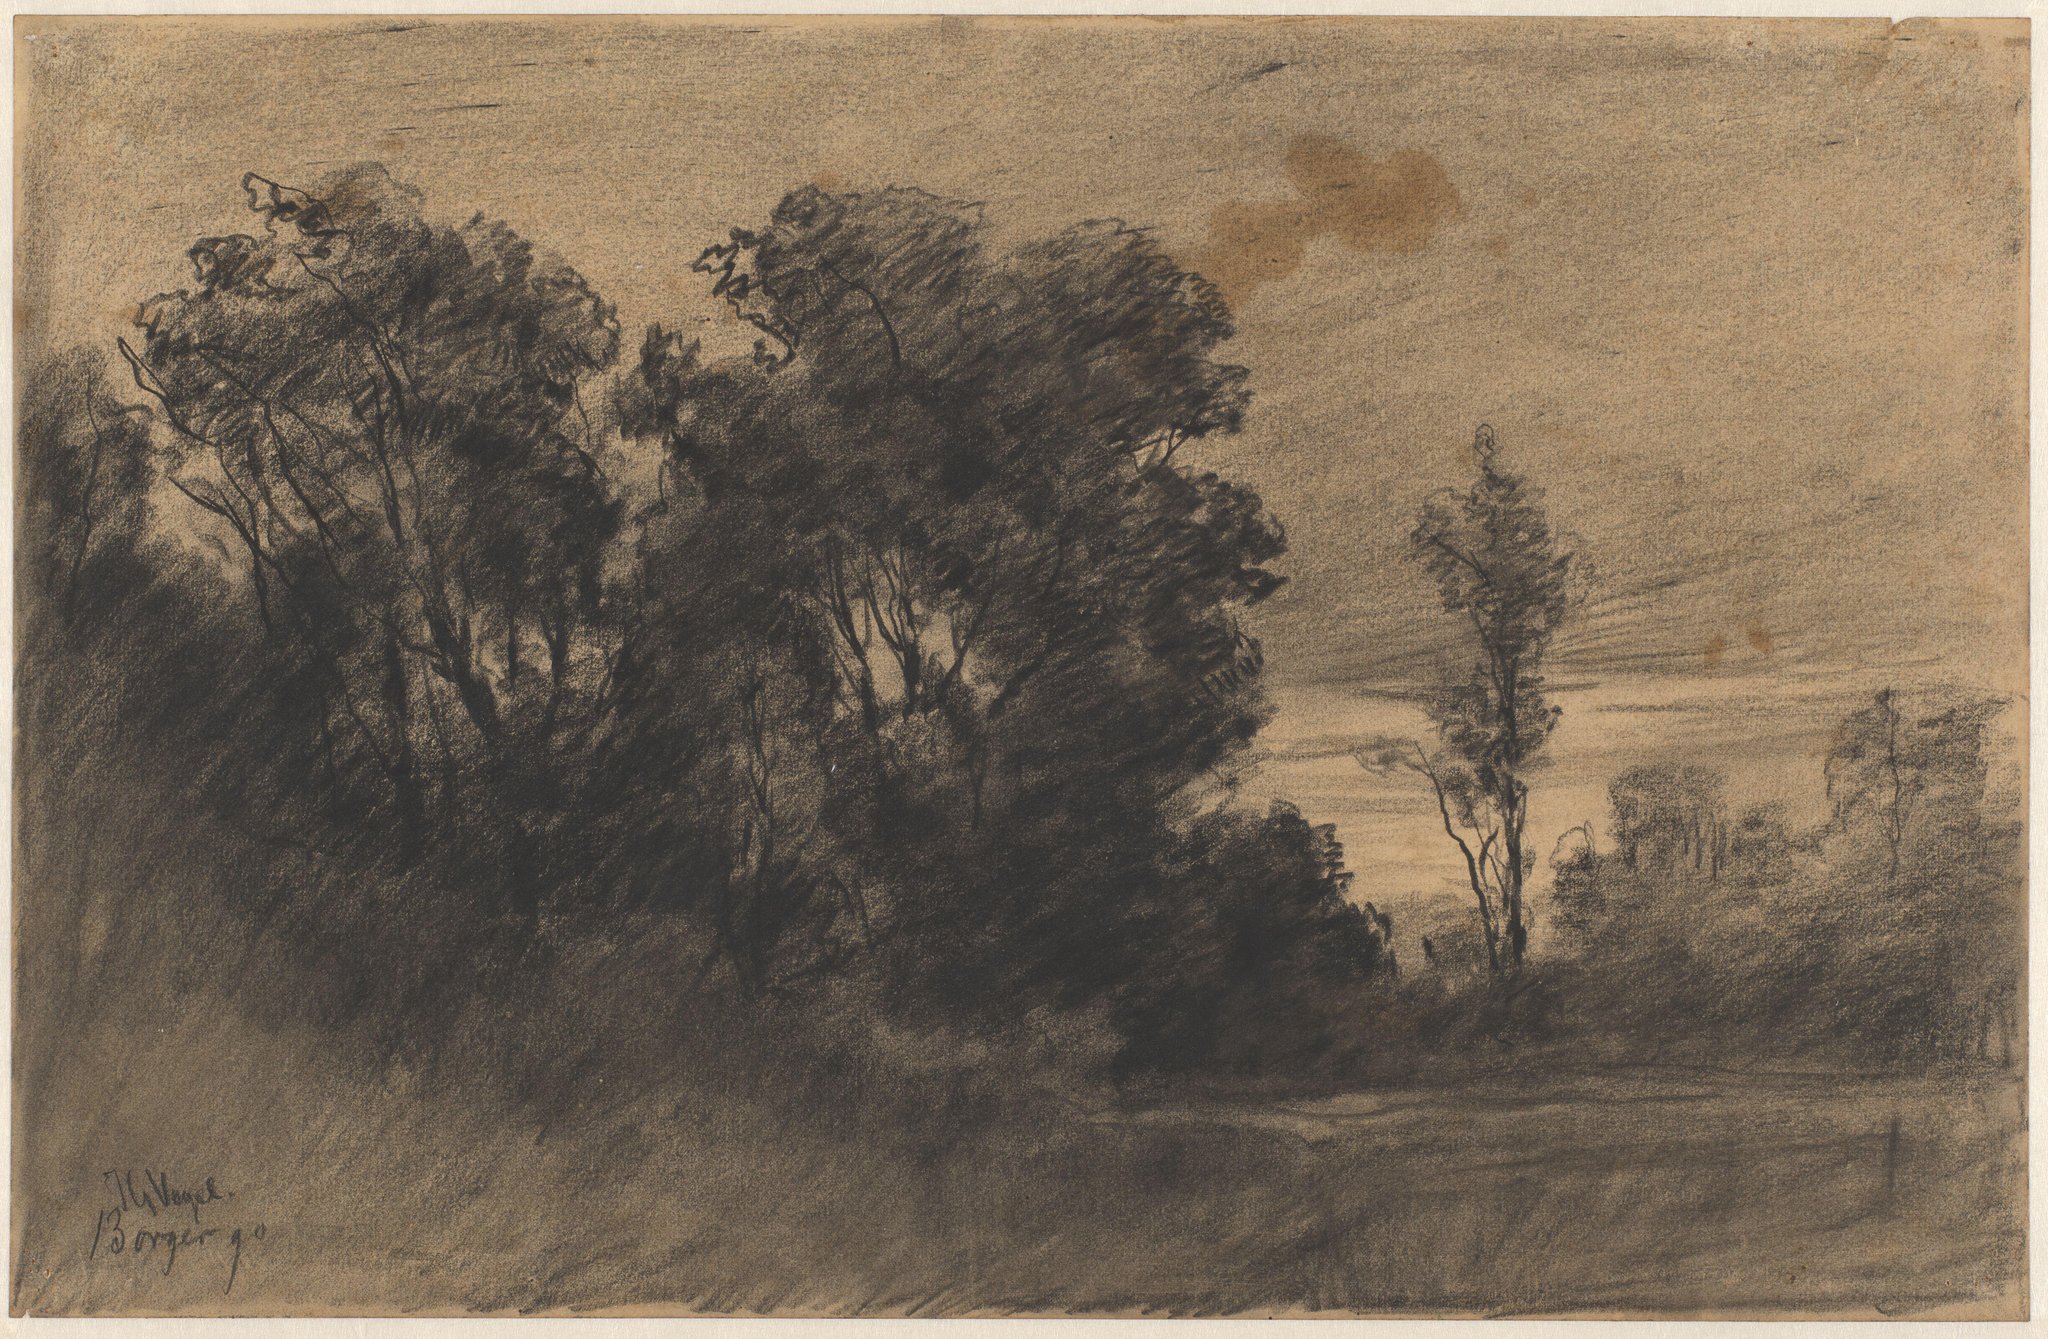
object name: drawing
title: Landschap te Borger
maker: johannes gijsbert vogel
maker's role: draughtsman, painter, print maker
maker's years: 1828-1915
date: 1890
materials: chalk, paper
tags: trees, landscapes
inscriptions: collector's mark: Lugt 1181b, date and inscription: ‘Borger 90’